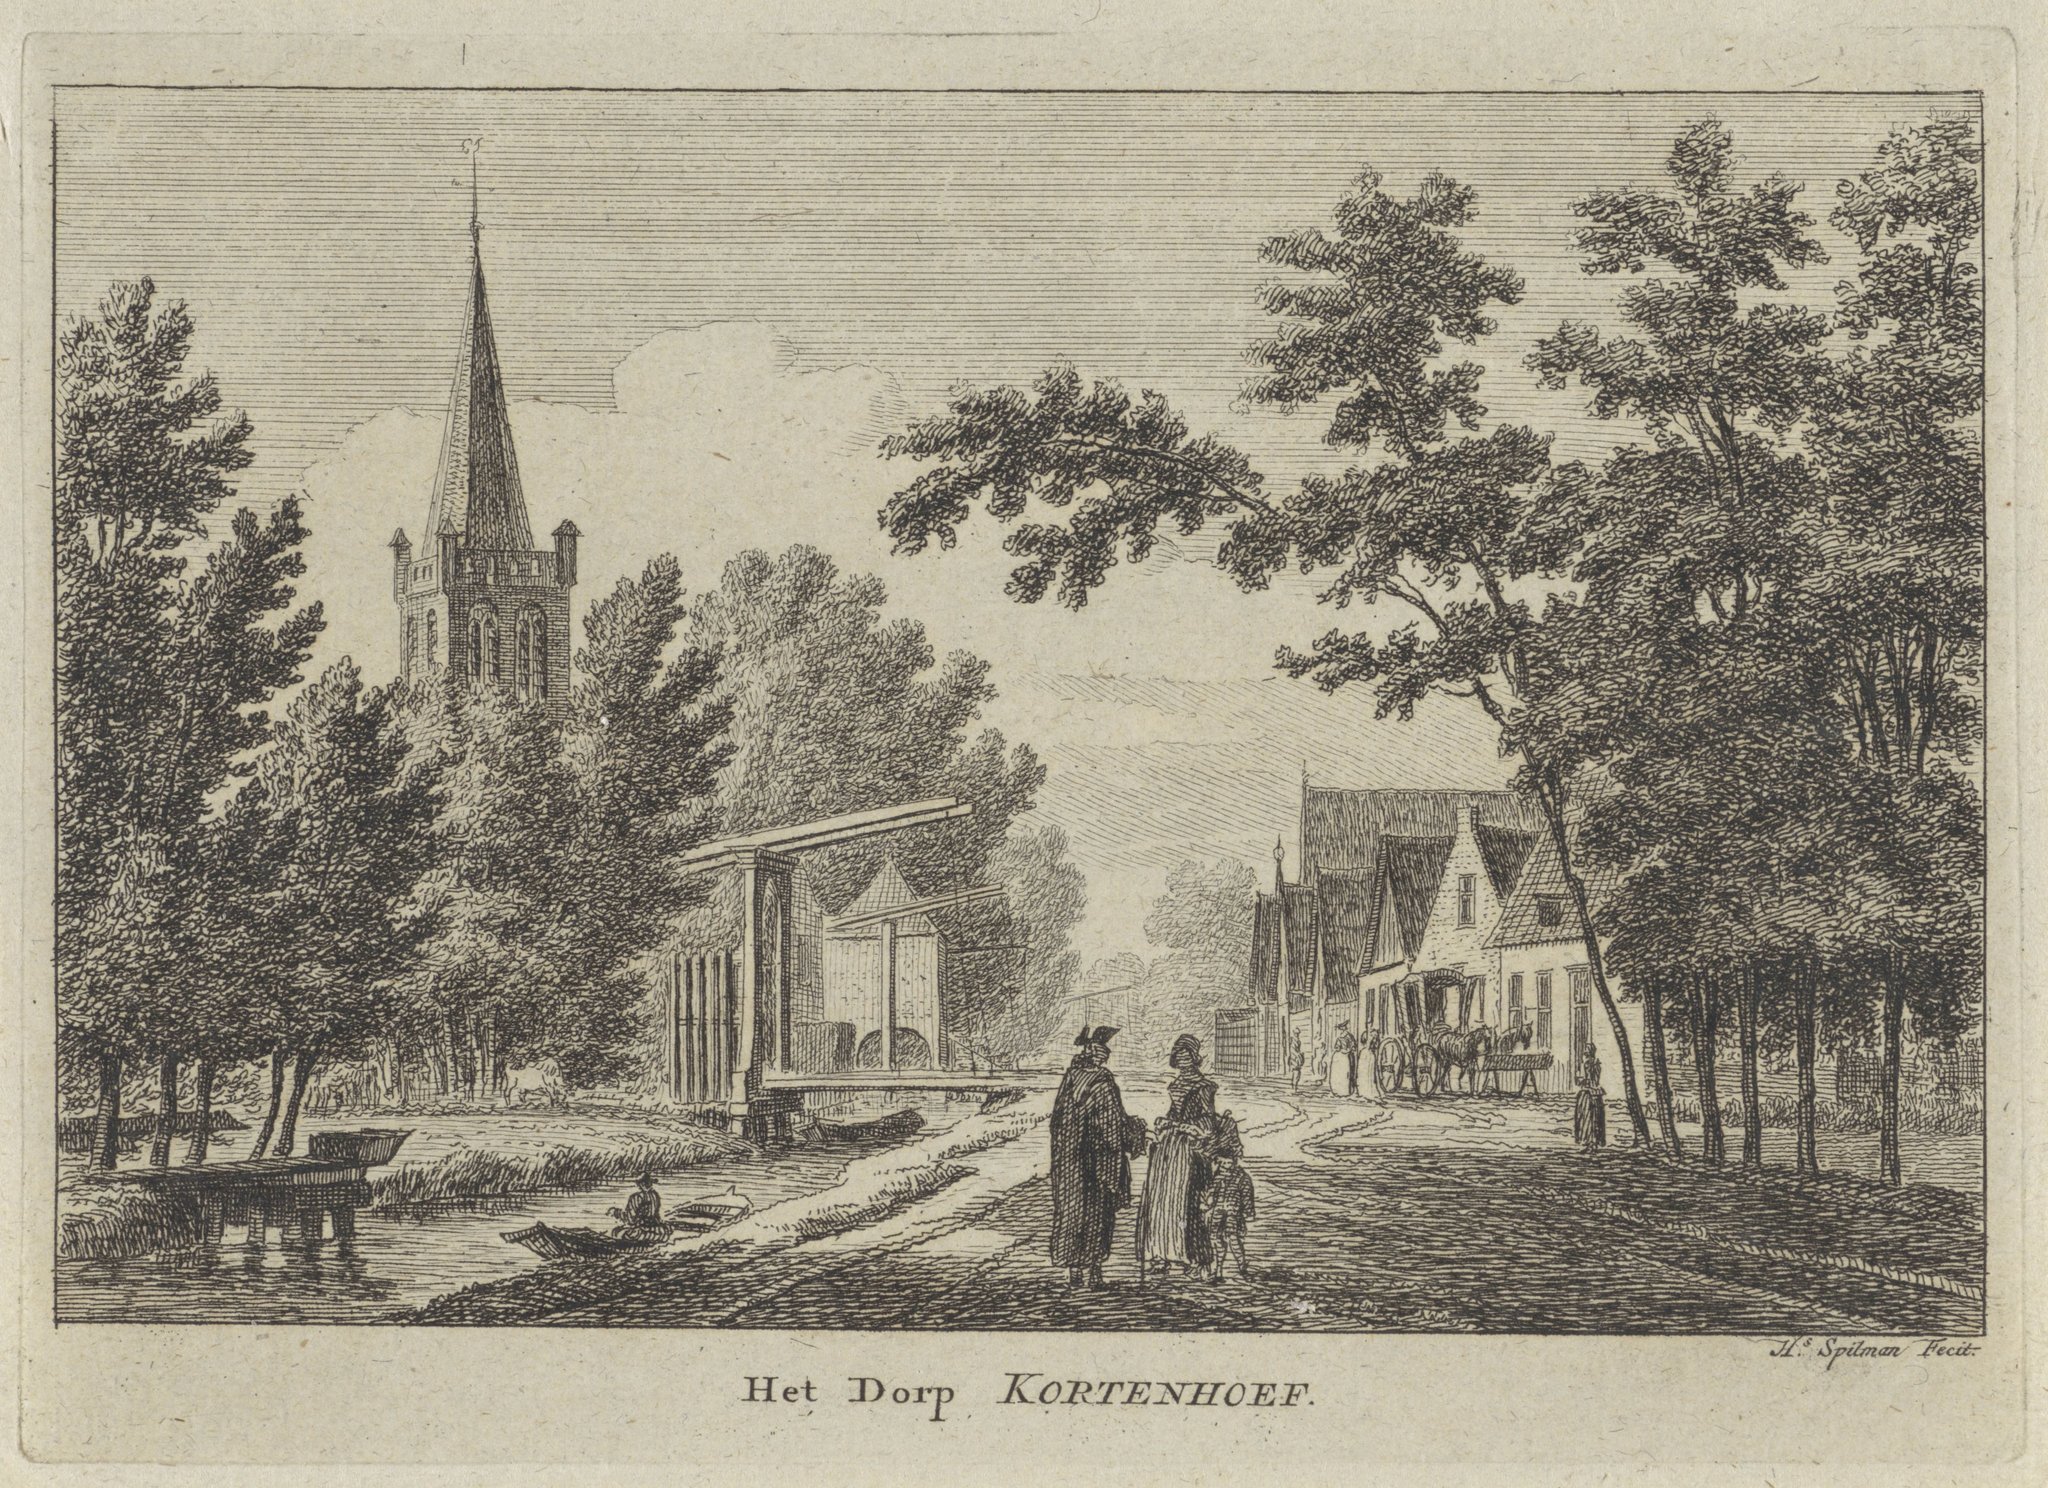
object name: print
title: Het Dorp Kortenhoef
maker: hendrik spilman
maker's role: draughtsman, painter, print maker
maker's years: 1721-1784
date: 1742-1784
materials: paper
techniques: etching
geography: haarlem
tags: bascule bridge, church (exterior), public road in village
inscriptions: collector's mark: Lugt 2228